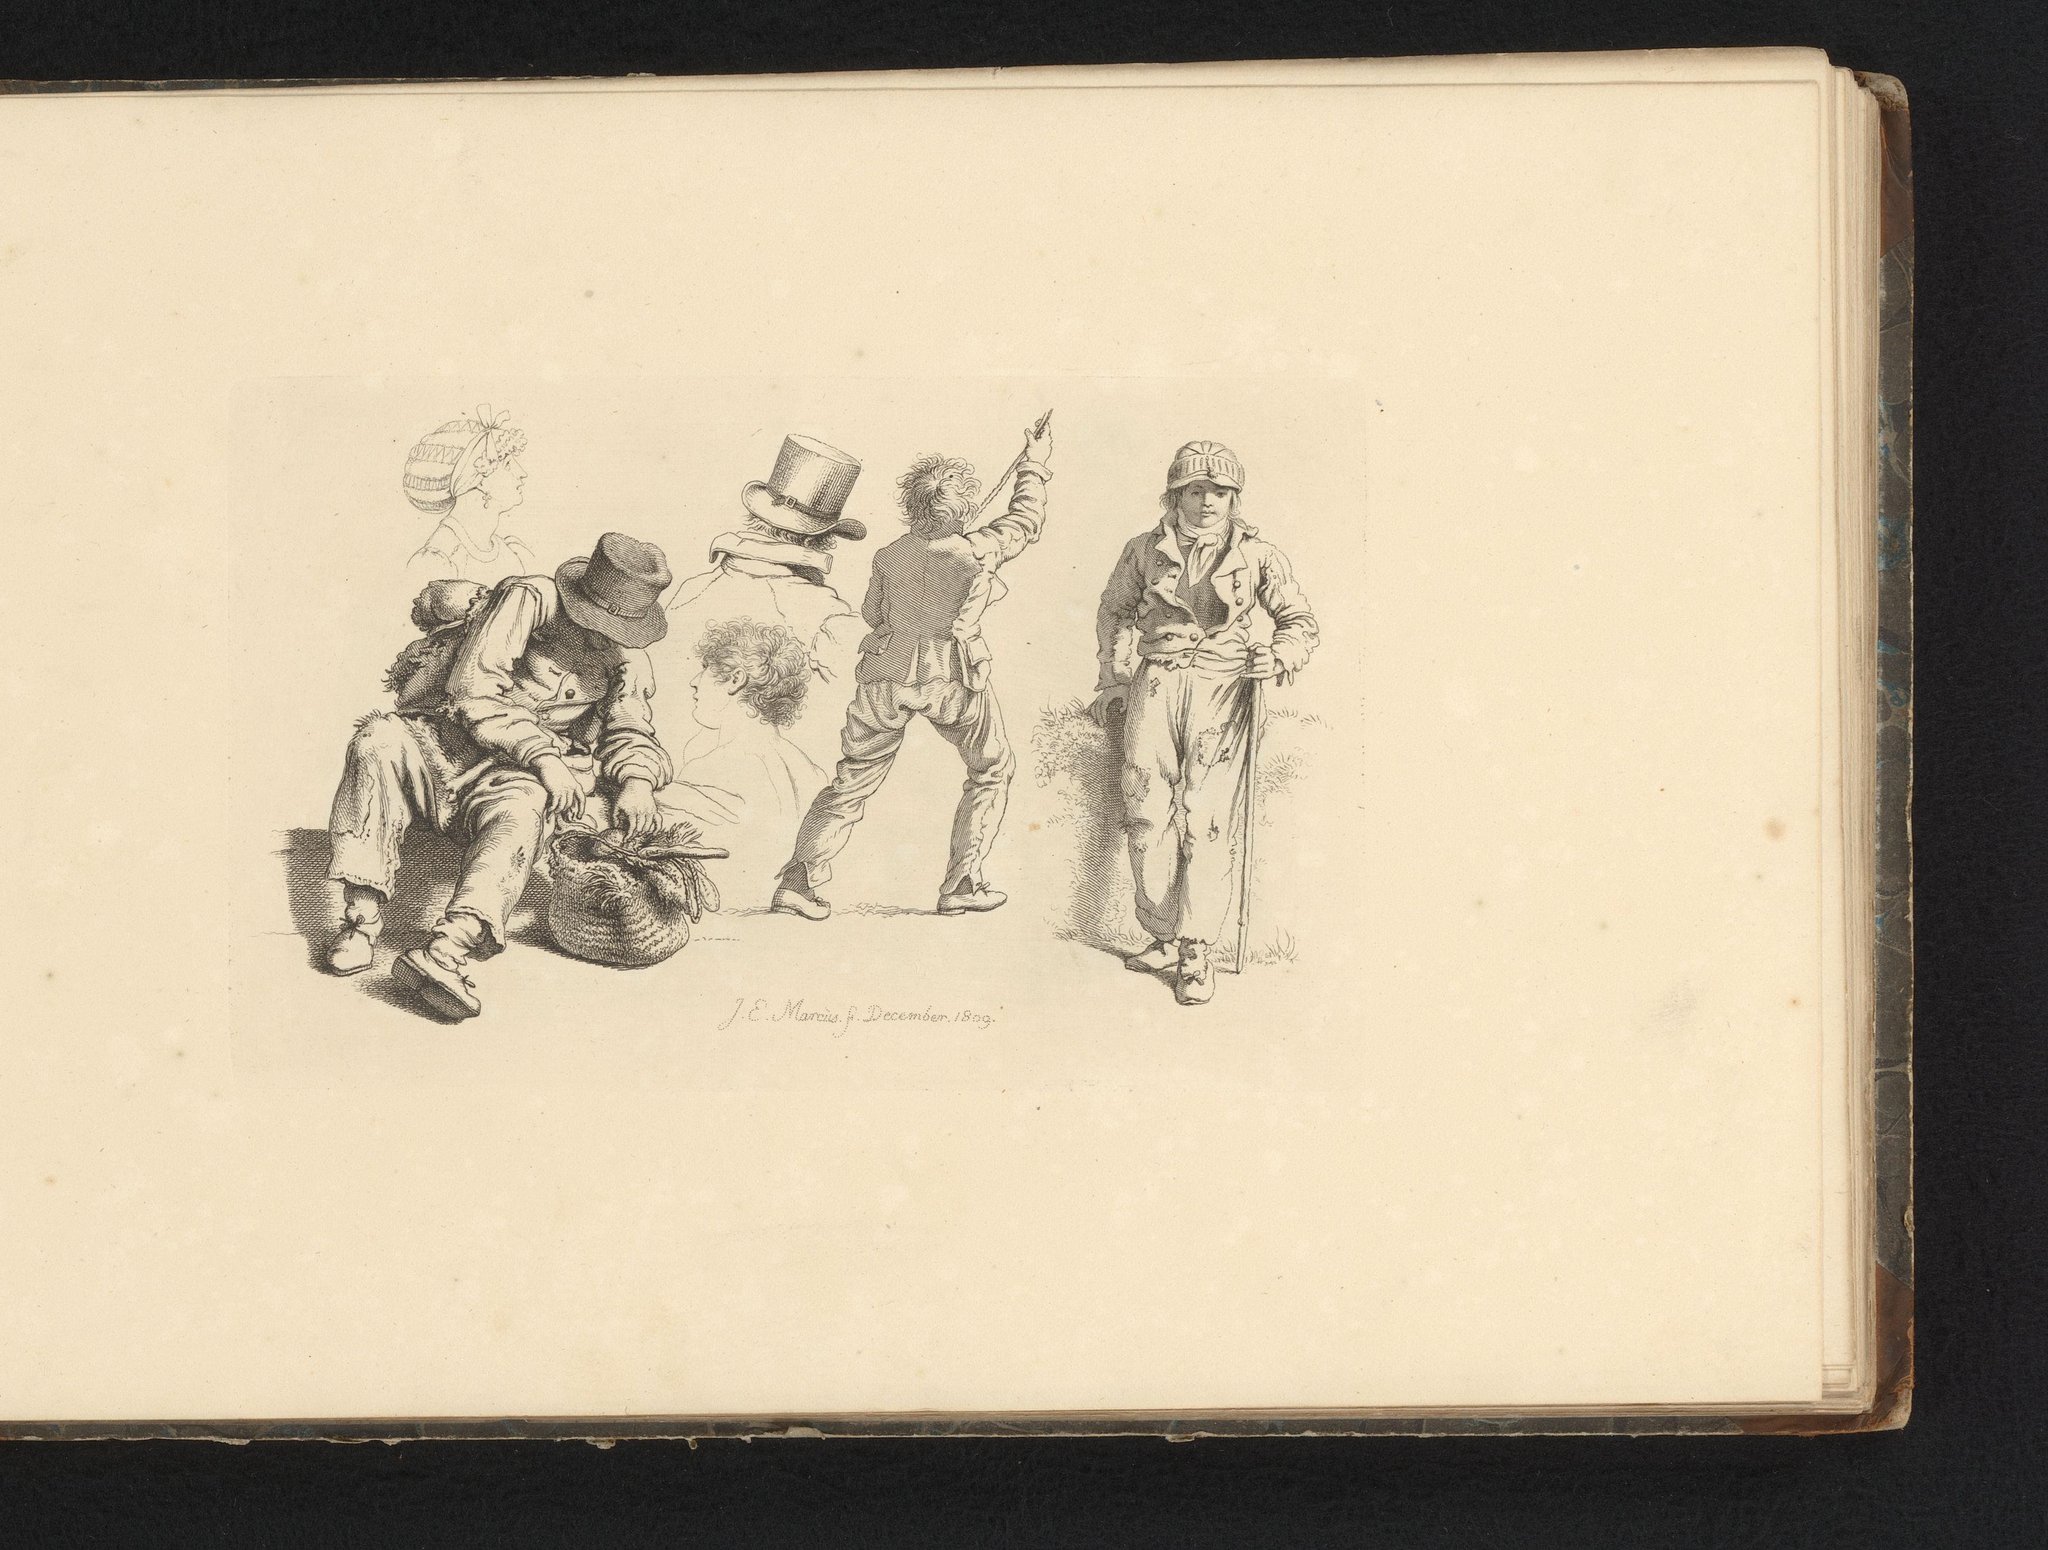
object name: print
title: Studieblad met drie figuren en drie hoofden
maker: jacob ernst marcus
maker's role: draughtsman, print maker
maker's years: 1774-1826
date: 1809-1812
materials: paper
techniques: etching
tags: vegetables, clothed in rags, container made of plant material other than wood: basket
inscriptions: date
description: Deze prent maakt deel uit van een album.